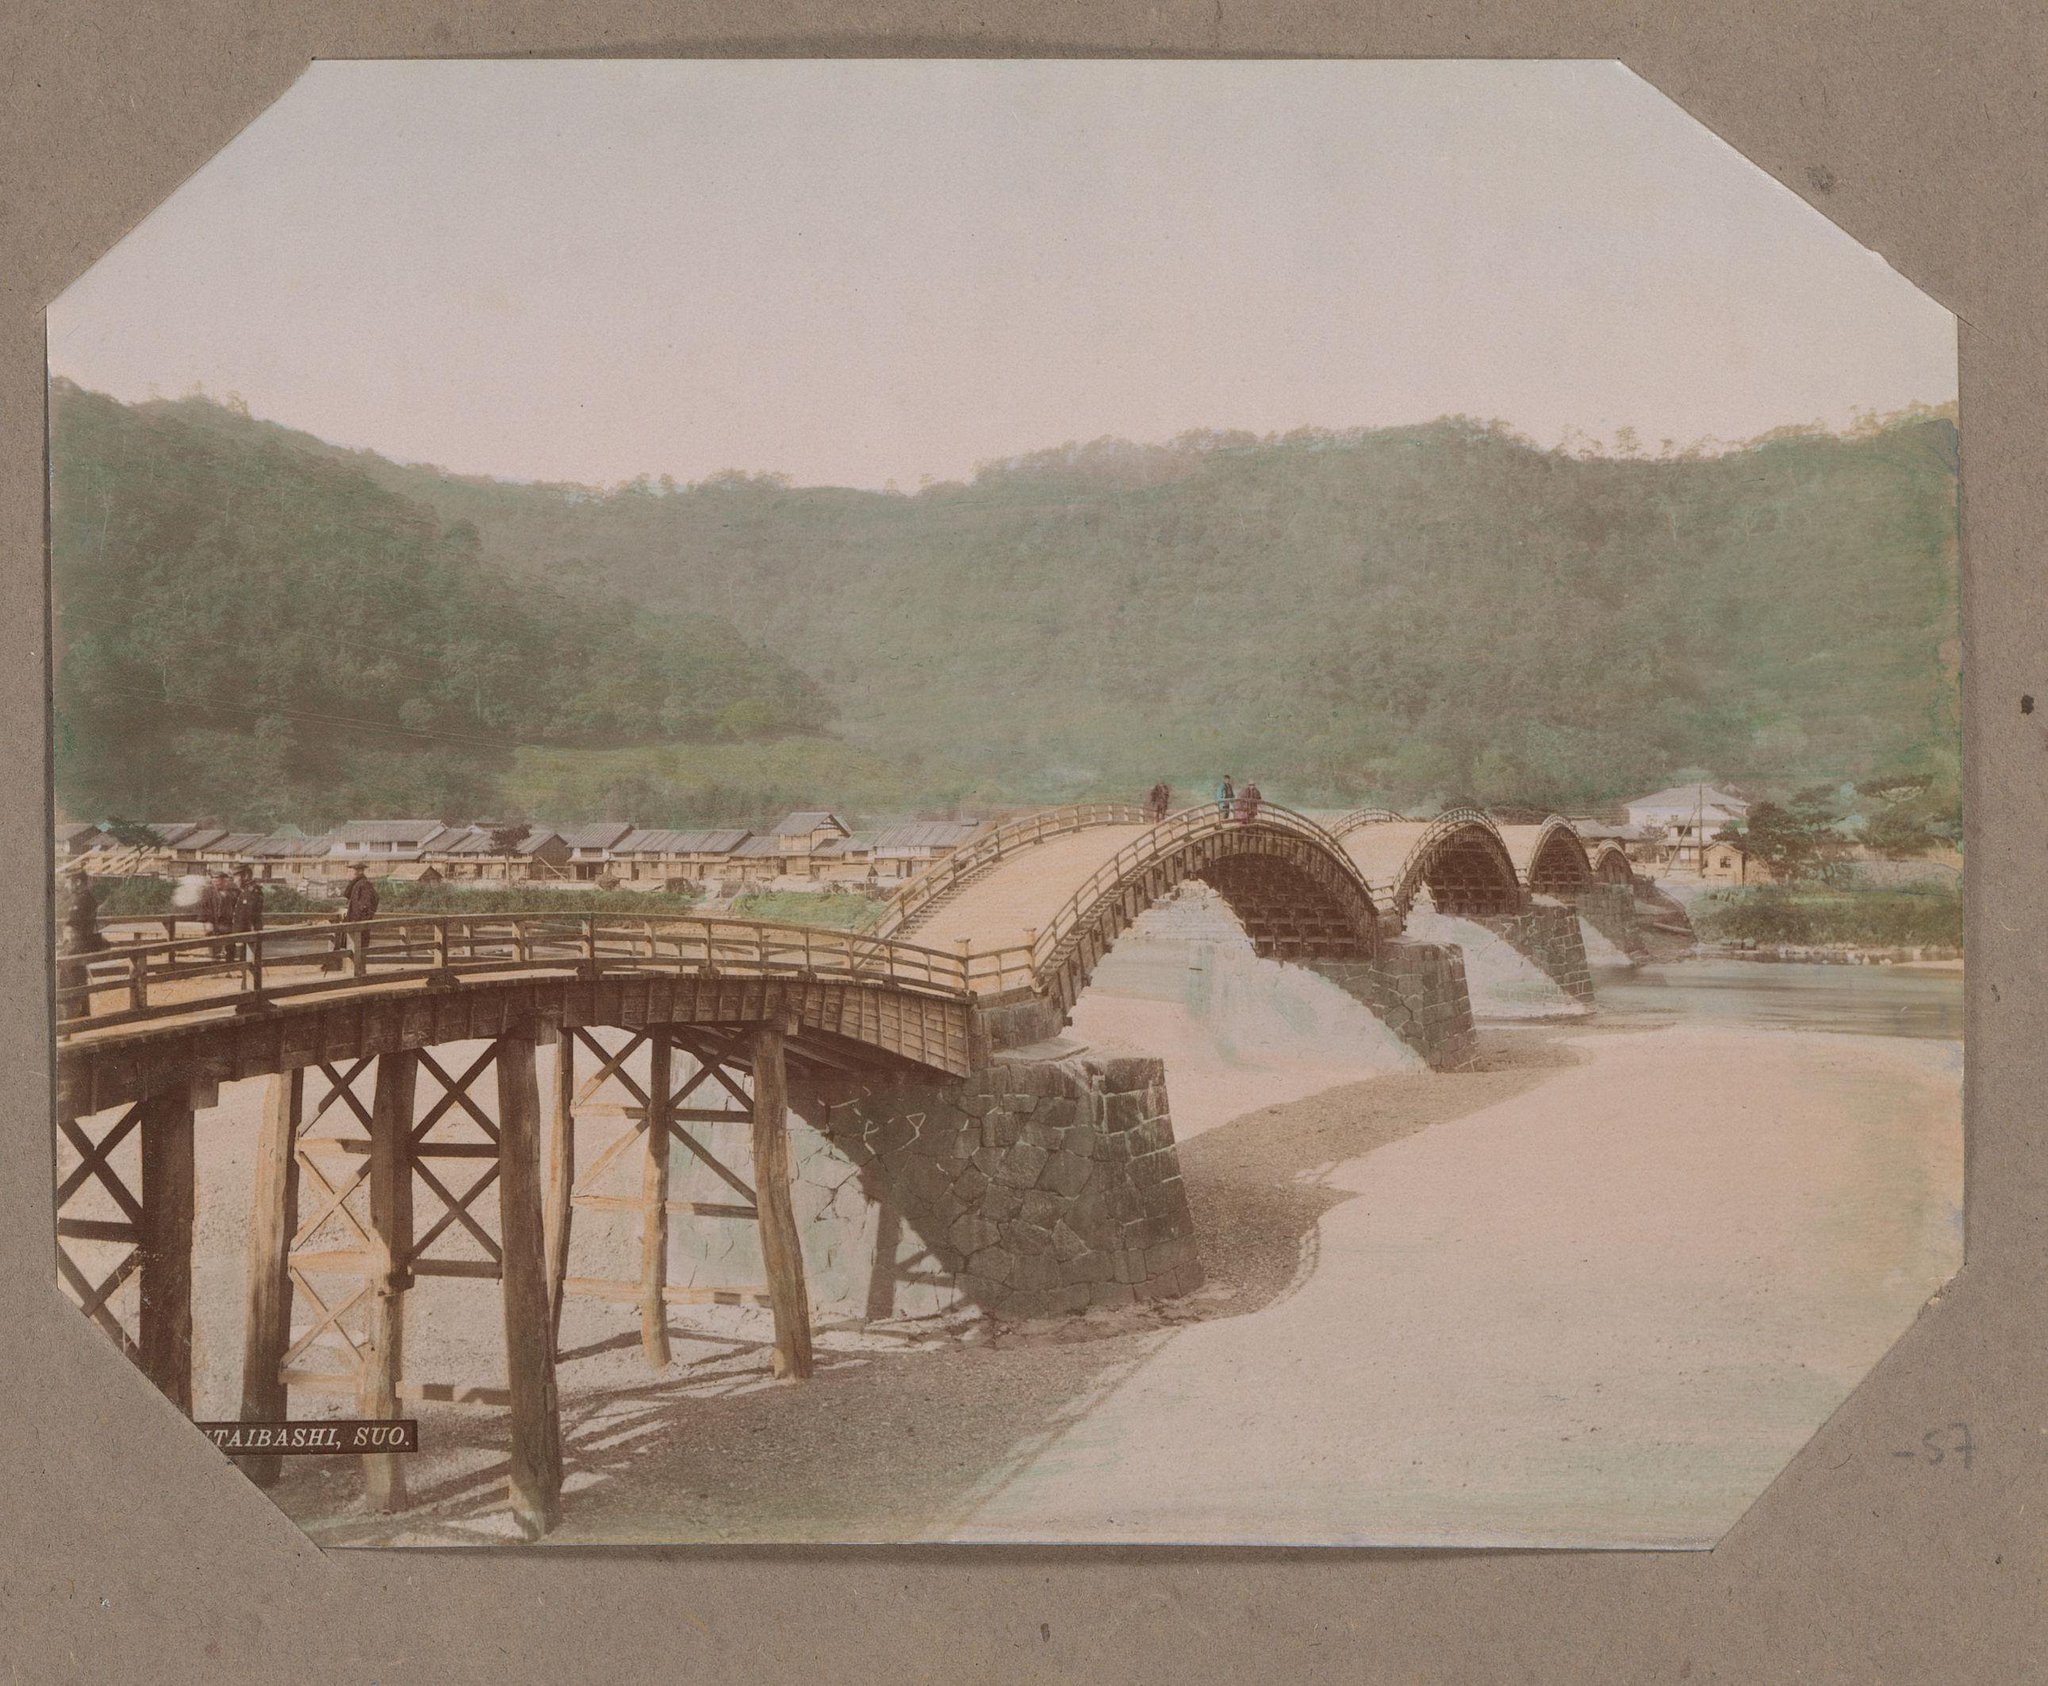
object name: photograph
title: Gezicht op de Kintai-kyo brug over de Nishiki rivier in Iwakuni, Japan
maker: Anonymous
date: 1890-1903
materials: paper, photographic support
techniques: albumen print, hand coloring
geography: iwakuni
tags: bridge in city across river, canal, etc.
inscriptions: inscription: ‘H 55. Kintaibashi, Suo’